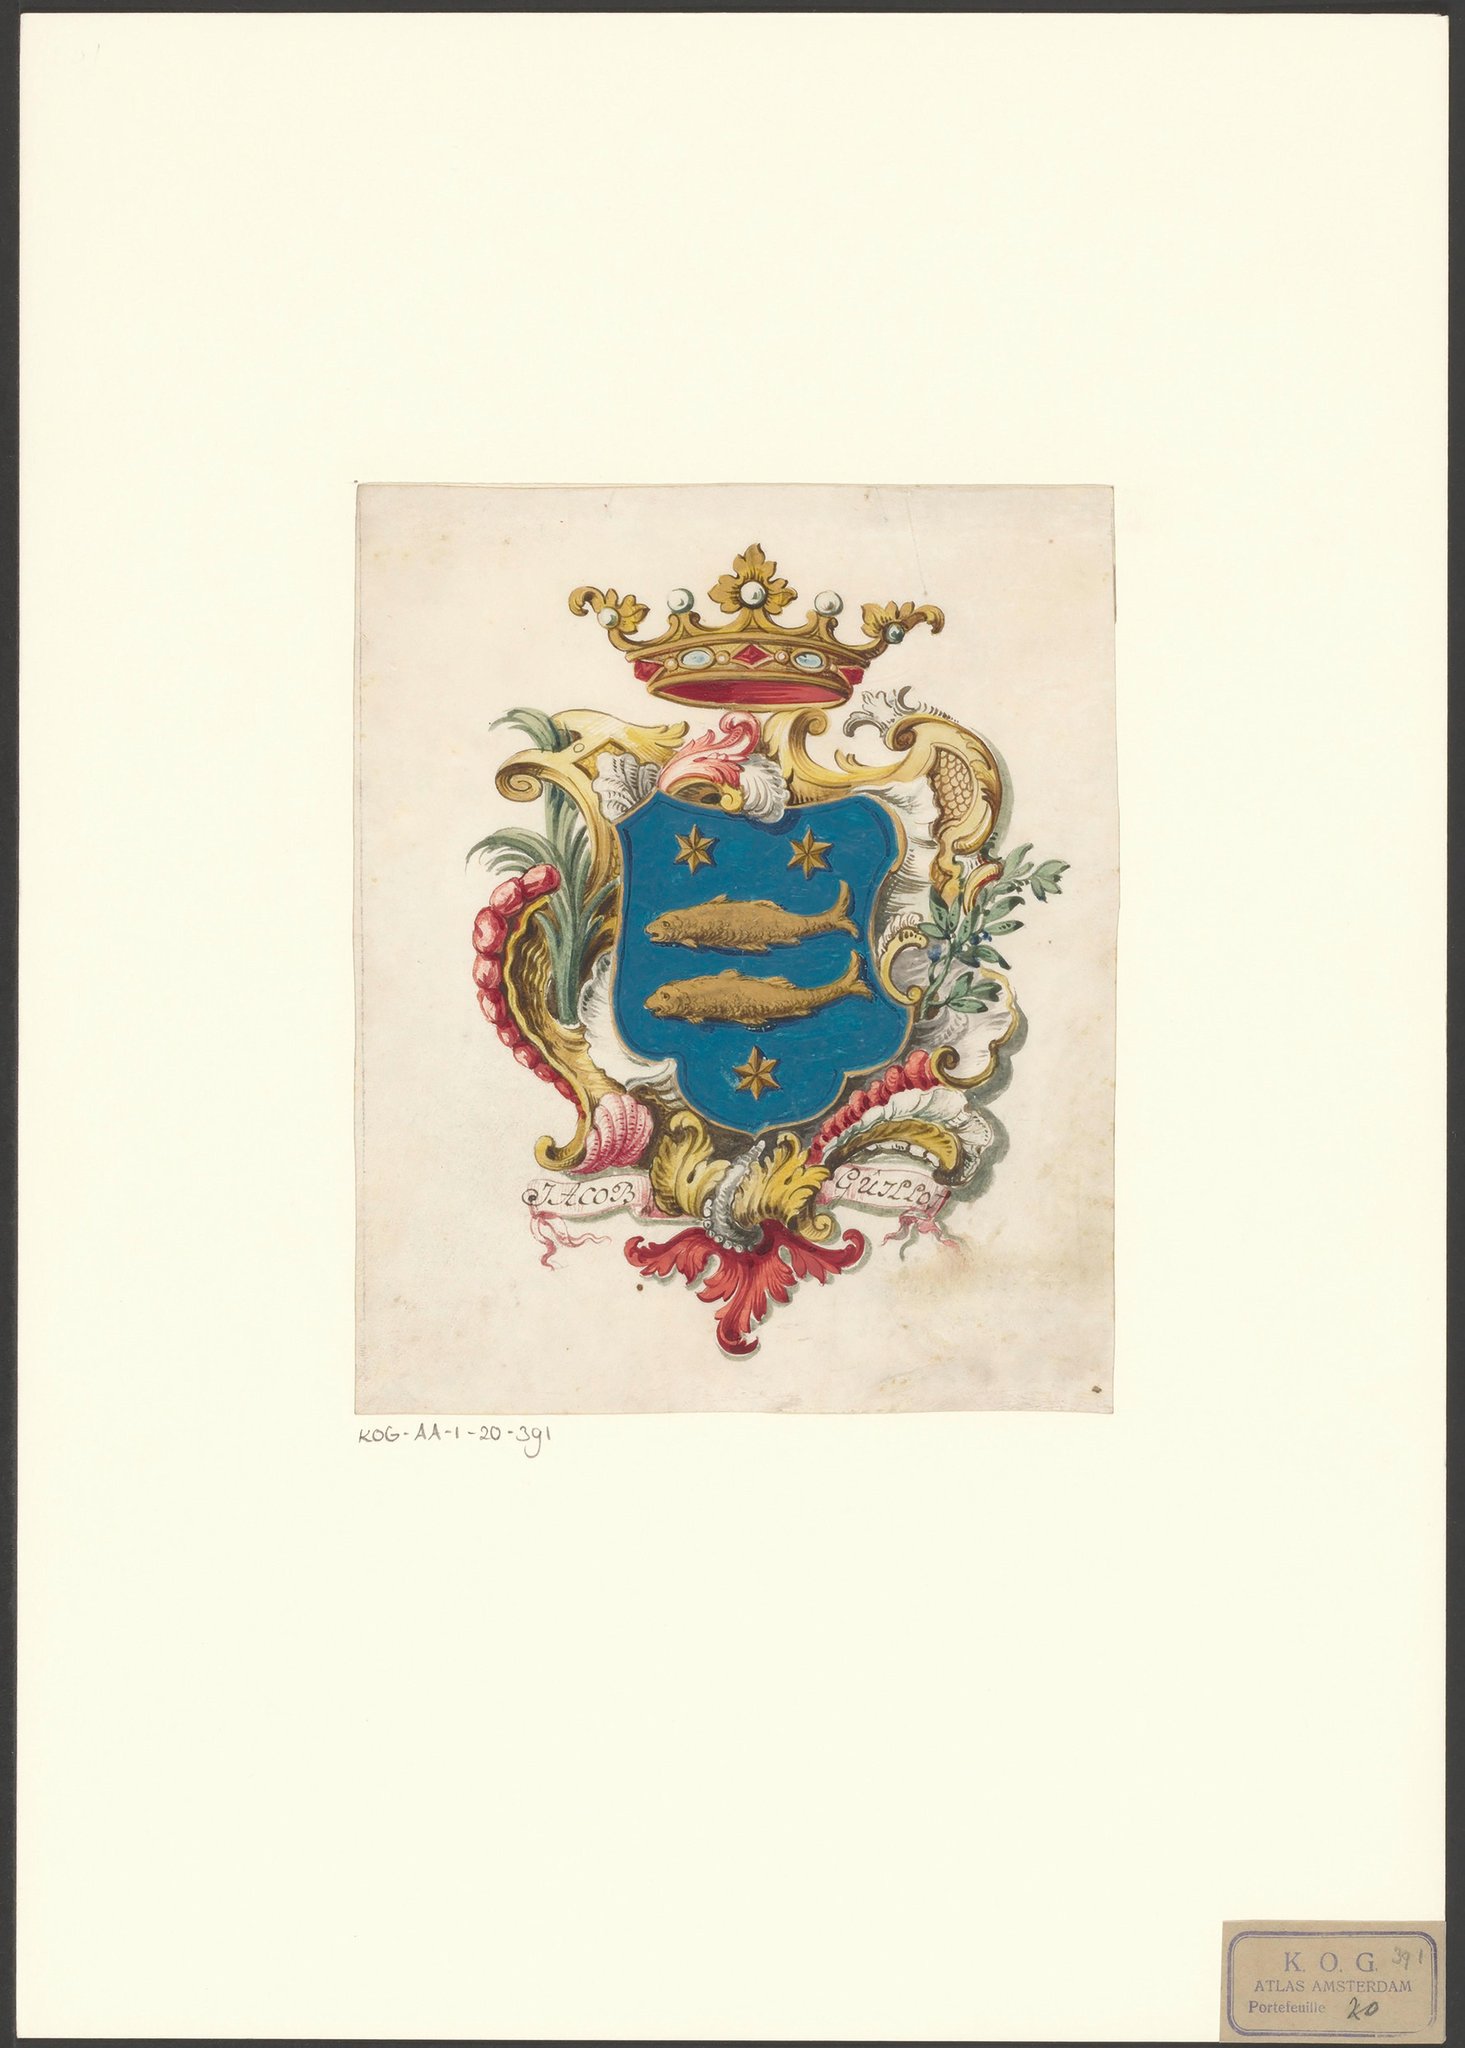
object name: drawing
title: Wapen van Jacob Guillot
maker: Anonymous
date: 1750-1850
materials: paint, paper, pencil, watercolor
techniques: brush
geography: amsterdam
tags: armorial bearing, heraldry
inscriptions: collector's mark: ‘20’ Lugt 1641b, inscription: ‘Port. 20-391’, inscription: ‘bruikleen / [...] maer / AA 471’